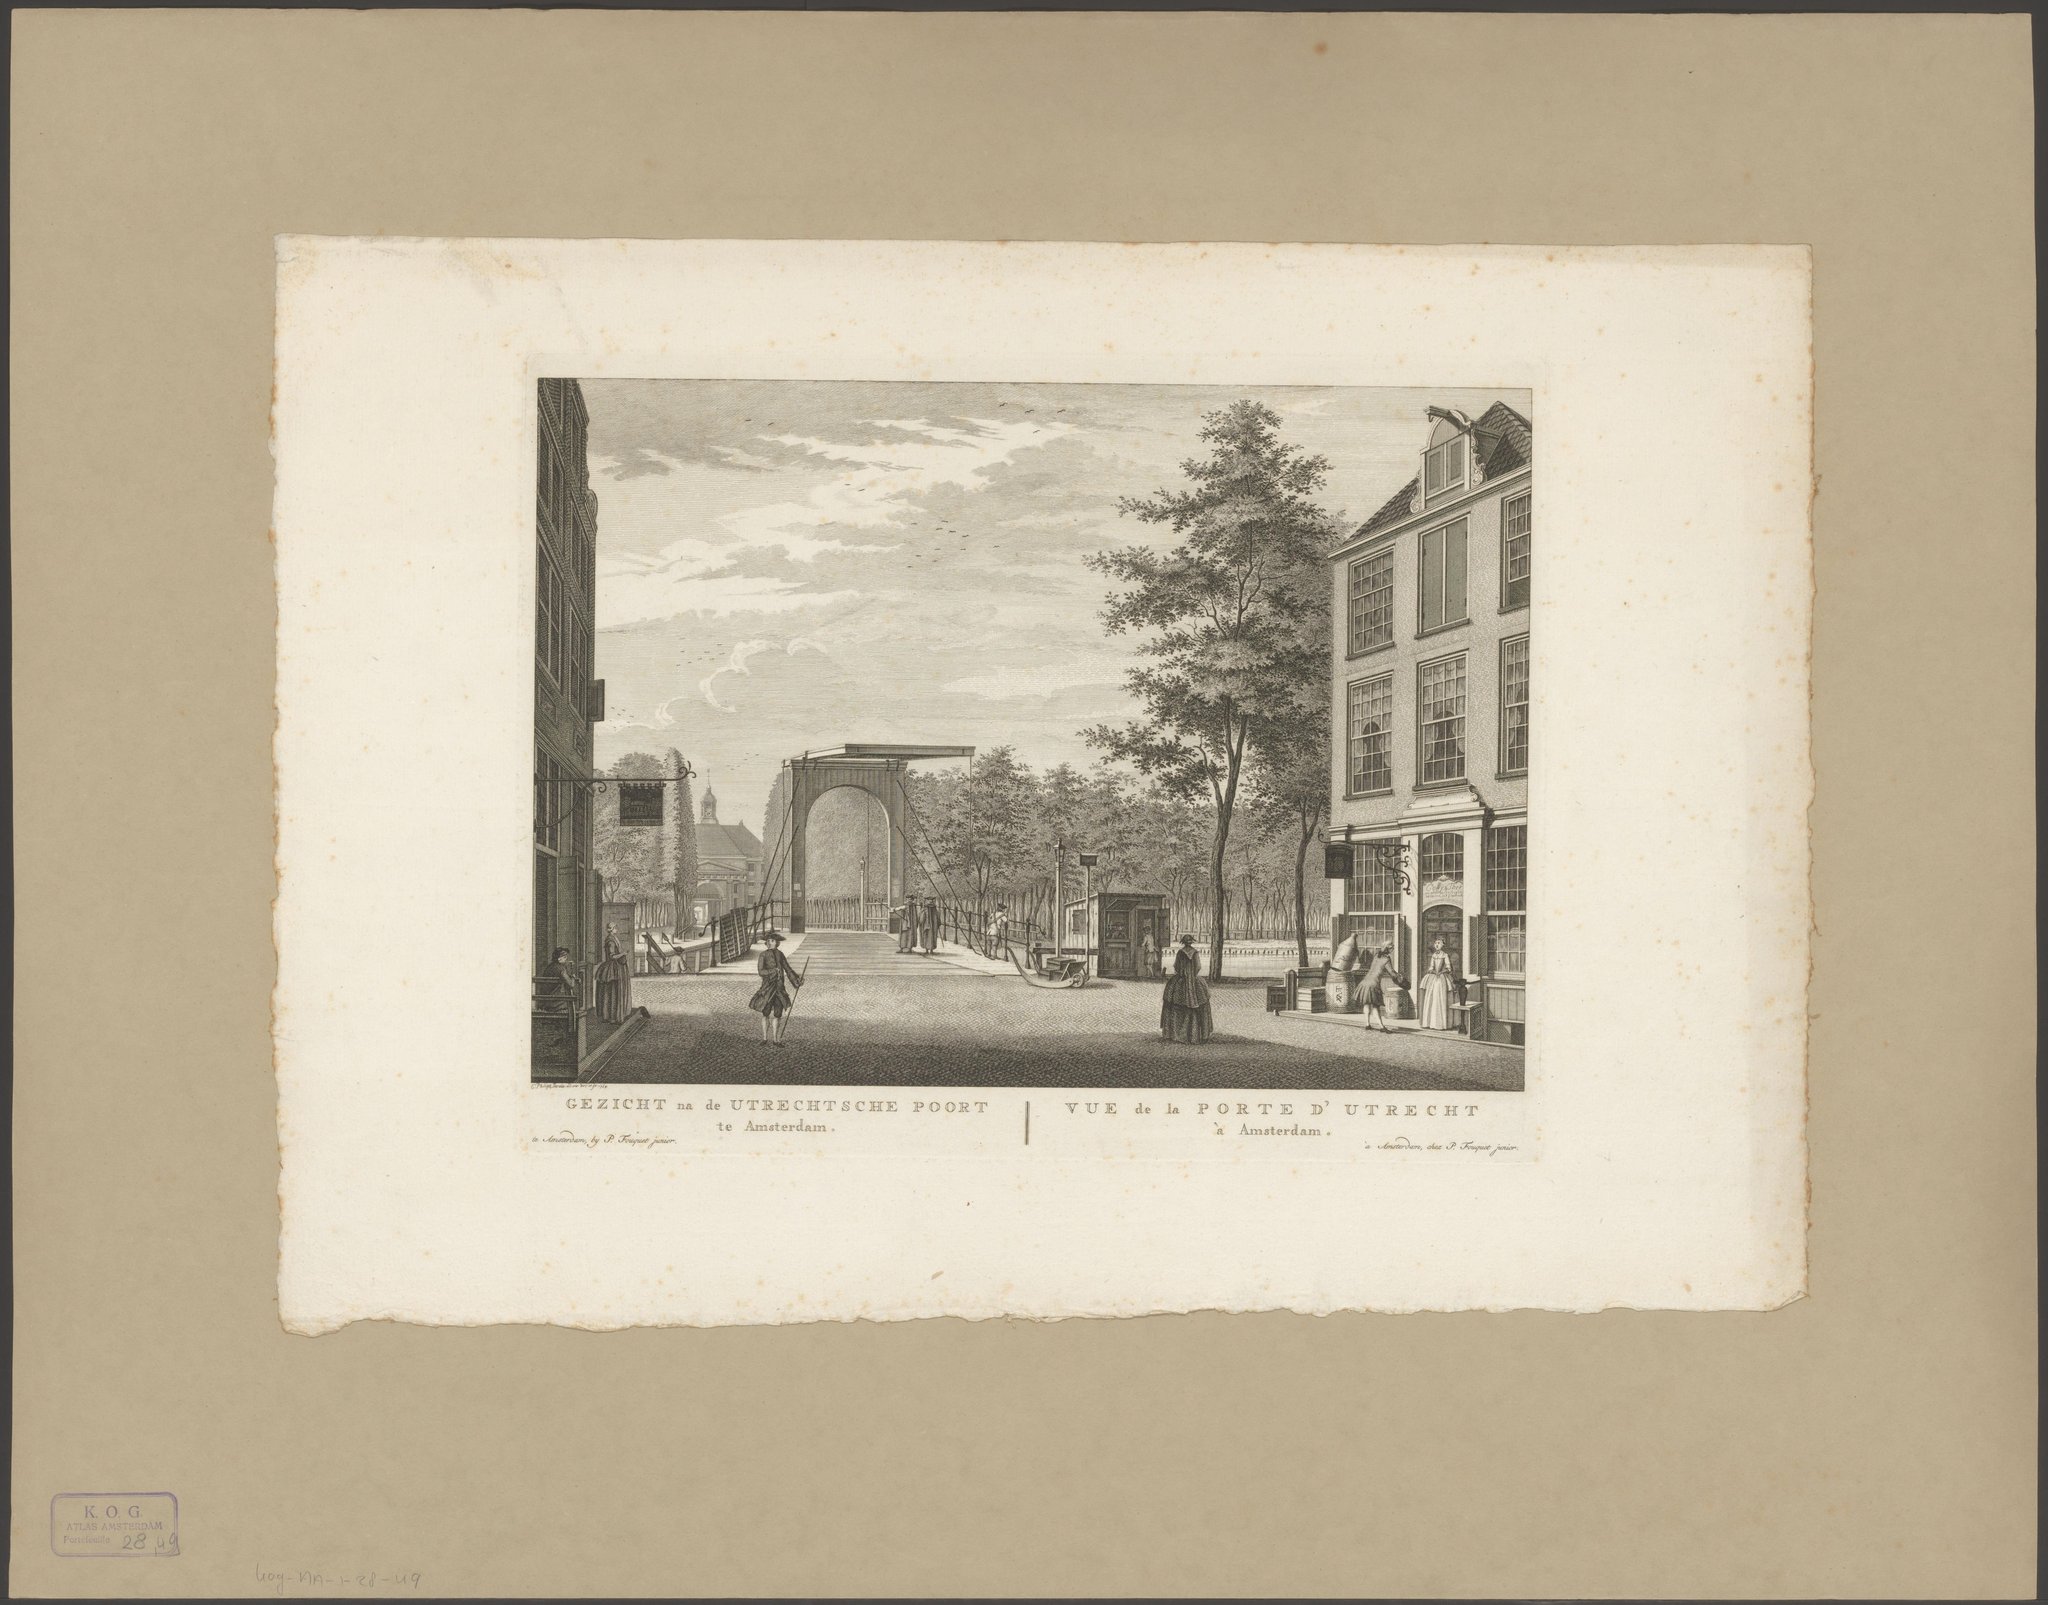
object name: print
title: Gezicht na de Utrechtsche Poort te Amsterdam / Vue de la Porte d'Utrecht à Amsterdam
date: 1764-1783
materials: paper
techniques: engraving, etching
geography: amsterdam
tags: bridge in city across river, canal, etc. (+ city(-scape) with figures, staffage), inn, coffee-house, public house, etc., canals, waters (in city), city-gate, street (+ city(-scape) with figures, staffage)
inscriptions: collector's mark: Lugt 1641b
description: Deze prent is ook gebruikt in de zogenaamde Atlas van Fouquet.* Pierre Fouquet gaf vanaf 1760 stadsgezichten van Amsterdam - naar tekeningen van verschillende kunstenaars, gemaakt door verschillende prentmakers - uit. Deze prenten werden aanvankelijk los of in series verkocht. Zoals toen gebruikelijk kon de koper de prenten zelf laten inbinden. Hiertoe gaf Fouquet tussen 1778 en 1783 een titelblad, plattegrond en inhoudsopgave van de tot dusver 100 uitgegeven prenten uit (1). Gezien de inhoud afhankelijk was van wat de koper had verzameld verschilt de inhoud van de verschillende bewaarde Fouquetatlassen onder deze titel sterk. Ook zijn er exemplaren bekend waar tevens andere prenten aan zijn toegevoegd. Omdat er behoefte bleek aan uitleg bij de platen werd in 1783 een nieuwe versie van de atlas uitgegeven, aangevuld met tekst en twee prenten. De aangegeven volgorde veranderde maar de platen van de al eerder uitgegeven prenten bleven ongewijzigd. Deze uitgave werd in opdracht van Fouquet gedrukt bij Daniël Jean Changuion en Petrus den Hengst (2). Een tiental platen werd bijgewerkt en verscheen, met nieuw impressum, in het vervolg van Wagenaars geschiedenis van Amsterdam, uitgeven door Petrus Conradi en Folkert van der Plaats (3). Een aantal jaar na het overlijden van Fouquet kwam Evert Maaskamp met een nieuwe uitgave van de atlas, met verbeterde tekst en toevoeging van twee prenten. Op alle platen verwijderde hij het oude en liet hij zijn eigen impressum zetten (4). Onder de Atlas van Fouquet of Fouquetatlas verstaan we de hieronder vermelde publicaties (1), (2) en (4). (1). Afbeeldingen van de wyd-vermaarde koopstad Amsterdam benevens des zelvs voornaamste gebouwen en gezigten alle naar het leeven getekend / Receuil des edifices les plus considerables et des plus belles vues, de la fameuse ville d'Amsterdam, dessinées d'après nature. Amsterdam: Pierre Fouquet, 1778-1783. (2). Nieuwe atlas, van de voornaamste gebouwen en gezigten der stad Amsterdam, met derzelver beknopte beschryvingen. 2 dln. Amsterdam: Daniël Jean Changuion en Petrus den Hengst [in opdracht van Pierre Fouquet], 1783. (3). Stijl, Simon. Amsterdam, in zyne geschiedenissen, voorregten, koophandel, gebouwen, kerkenstaat, schoolen, schutterye, gilden en regeeringe, beschreeven. Om te dienen ten vervolge op het werk van Jan Wagenaar (…). 10 dln. Amsterdam en Harlingen: Petrus Conradi en Folkert van der Plaats, 1788-1801. (4). Nieuwe atlas, van de voornaamste gebouwen en gezigten der stad Amsterdam. Met derzelver beknopte beschryvingen. Amsterdam: Evert Maaskamp, 1805. * Het aantal vermelde staten is gebaseerd op het aantal gevonden staten. Mogelijk zijn er meer staten van deze prent.